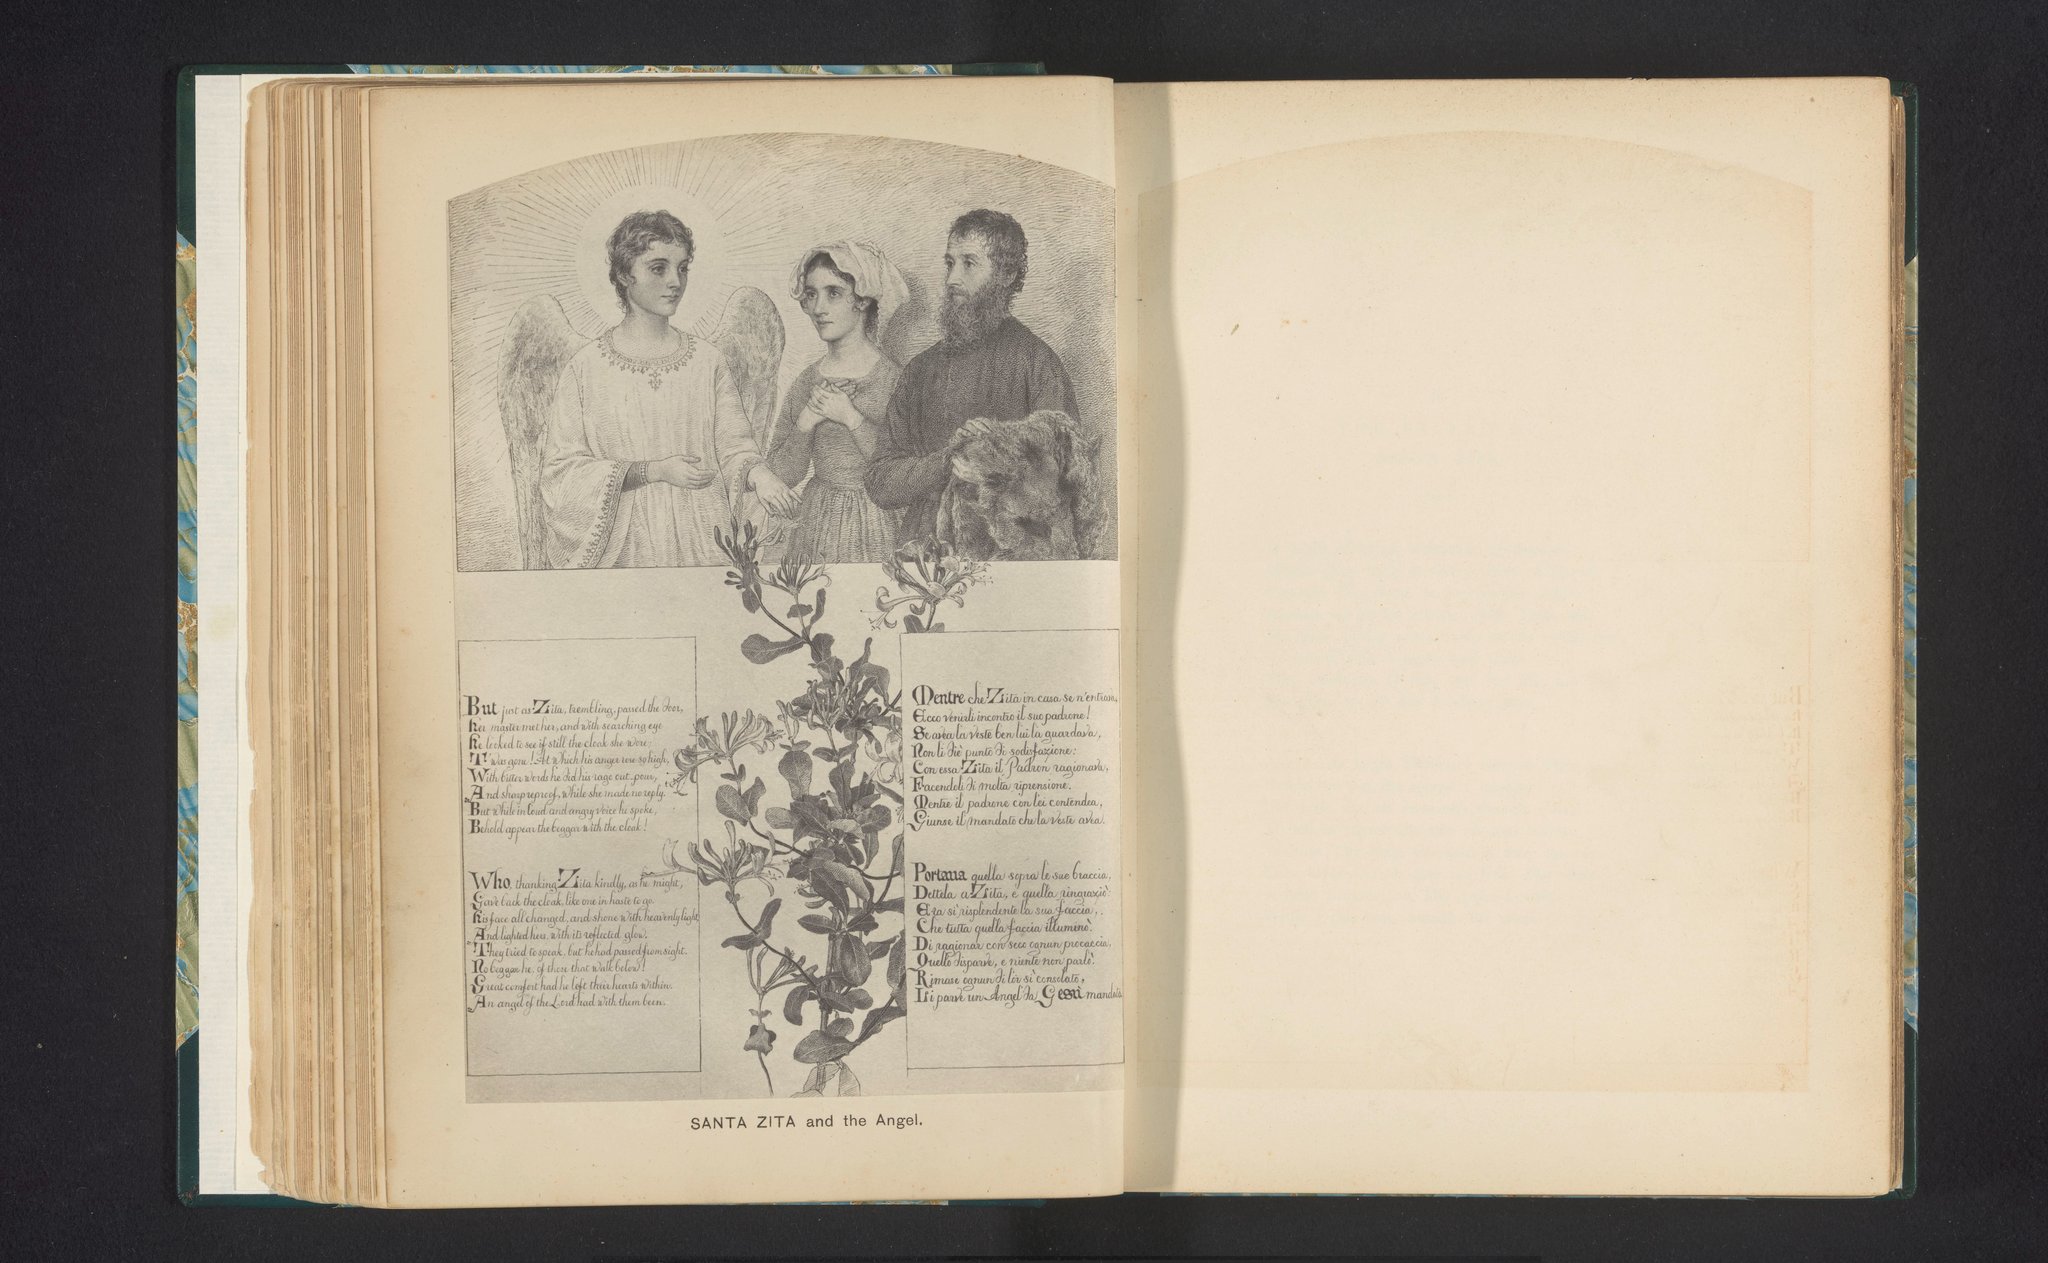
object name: reproduction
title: Santa Zita and the angel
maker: frederick hollyer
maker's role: fotograaf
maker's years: 1838-1933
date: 1875-1885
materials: photographic support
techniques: platinum process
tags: female saints, angels, coat, cape